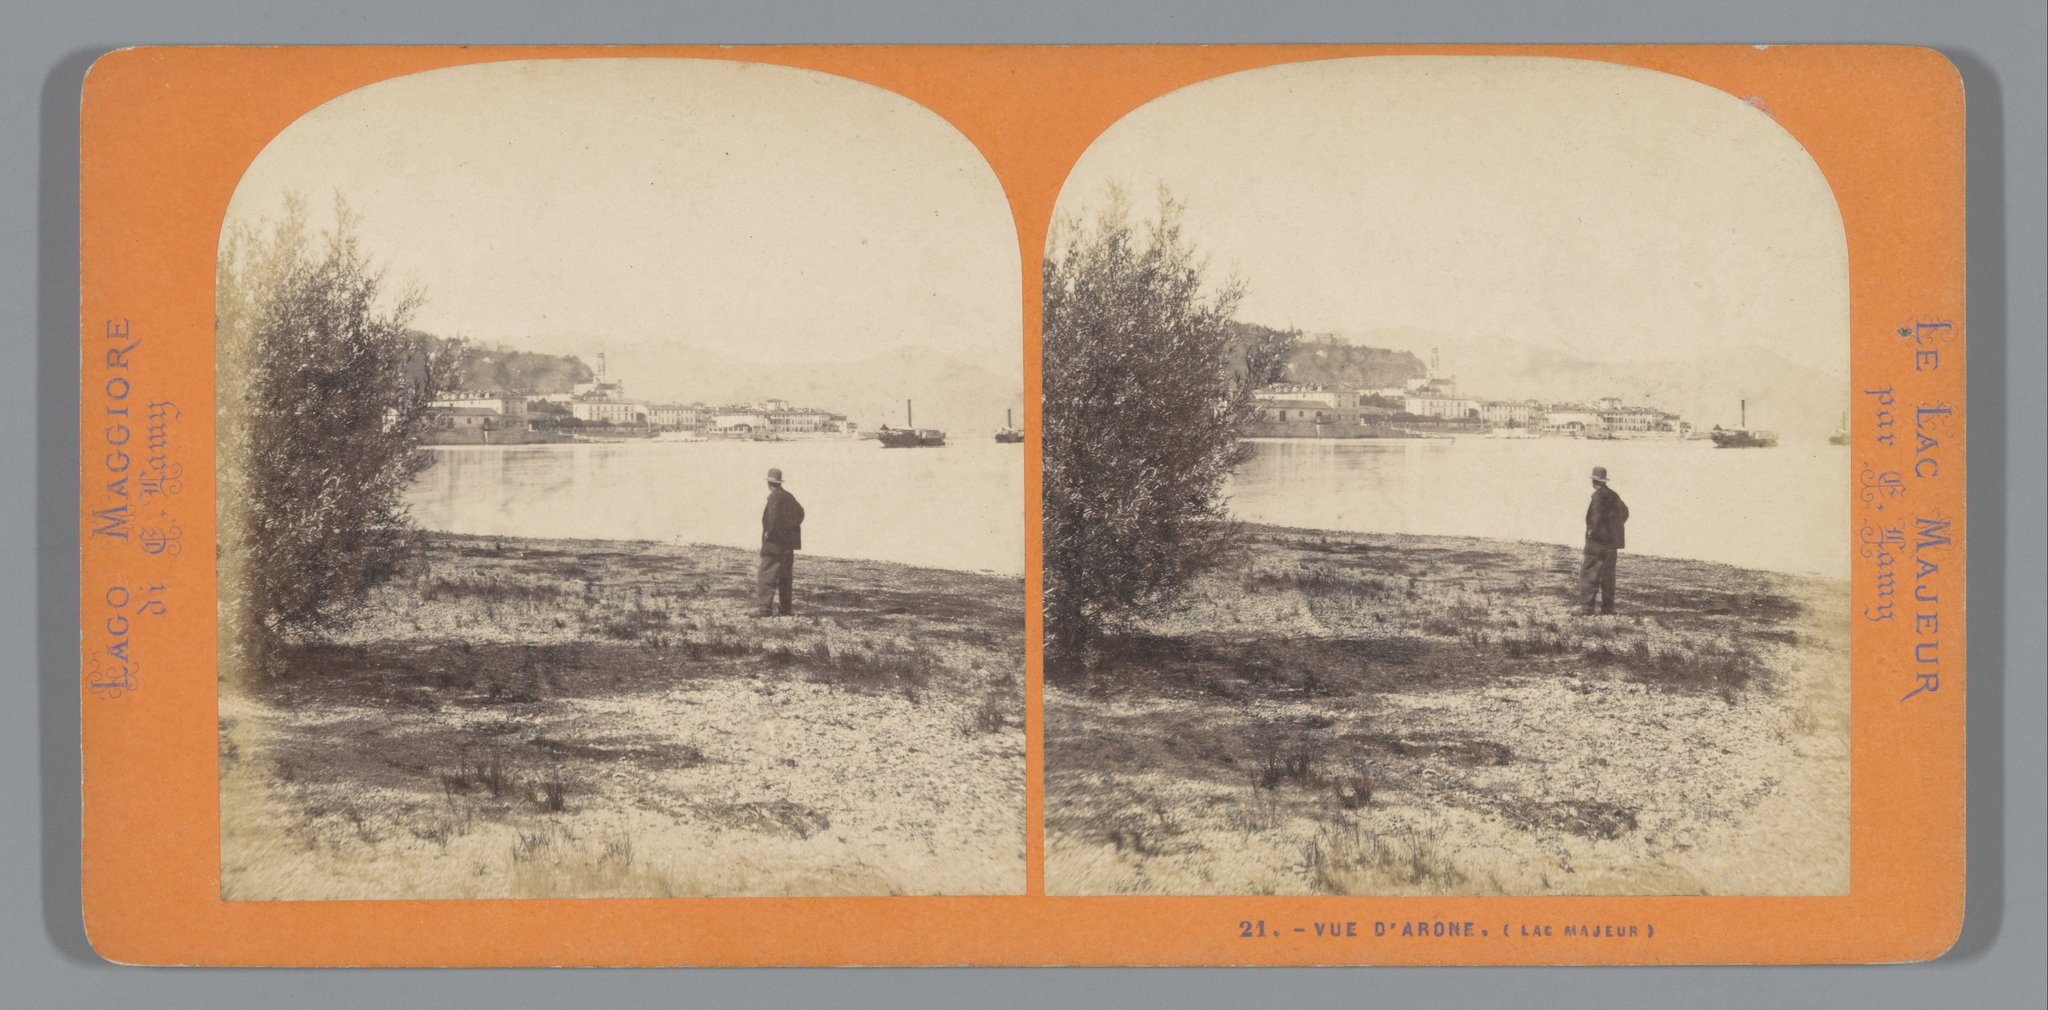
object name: stereograph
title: Vue d'Arône. (Lac Majeur)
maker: ernest eléonor pierre lamy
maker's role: publisher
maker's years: 1828-1900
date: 1861-1878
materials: cardboard, paper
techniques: albumen print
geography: lake maggiore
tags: lake, coast, steamship, motorship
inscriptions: number: ‘21.’